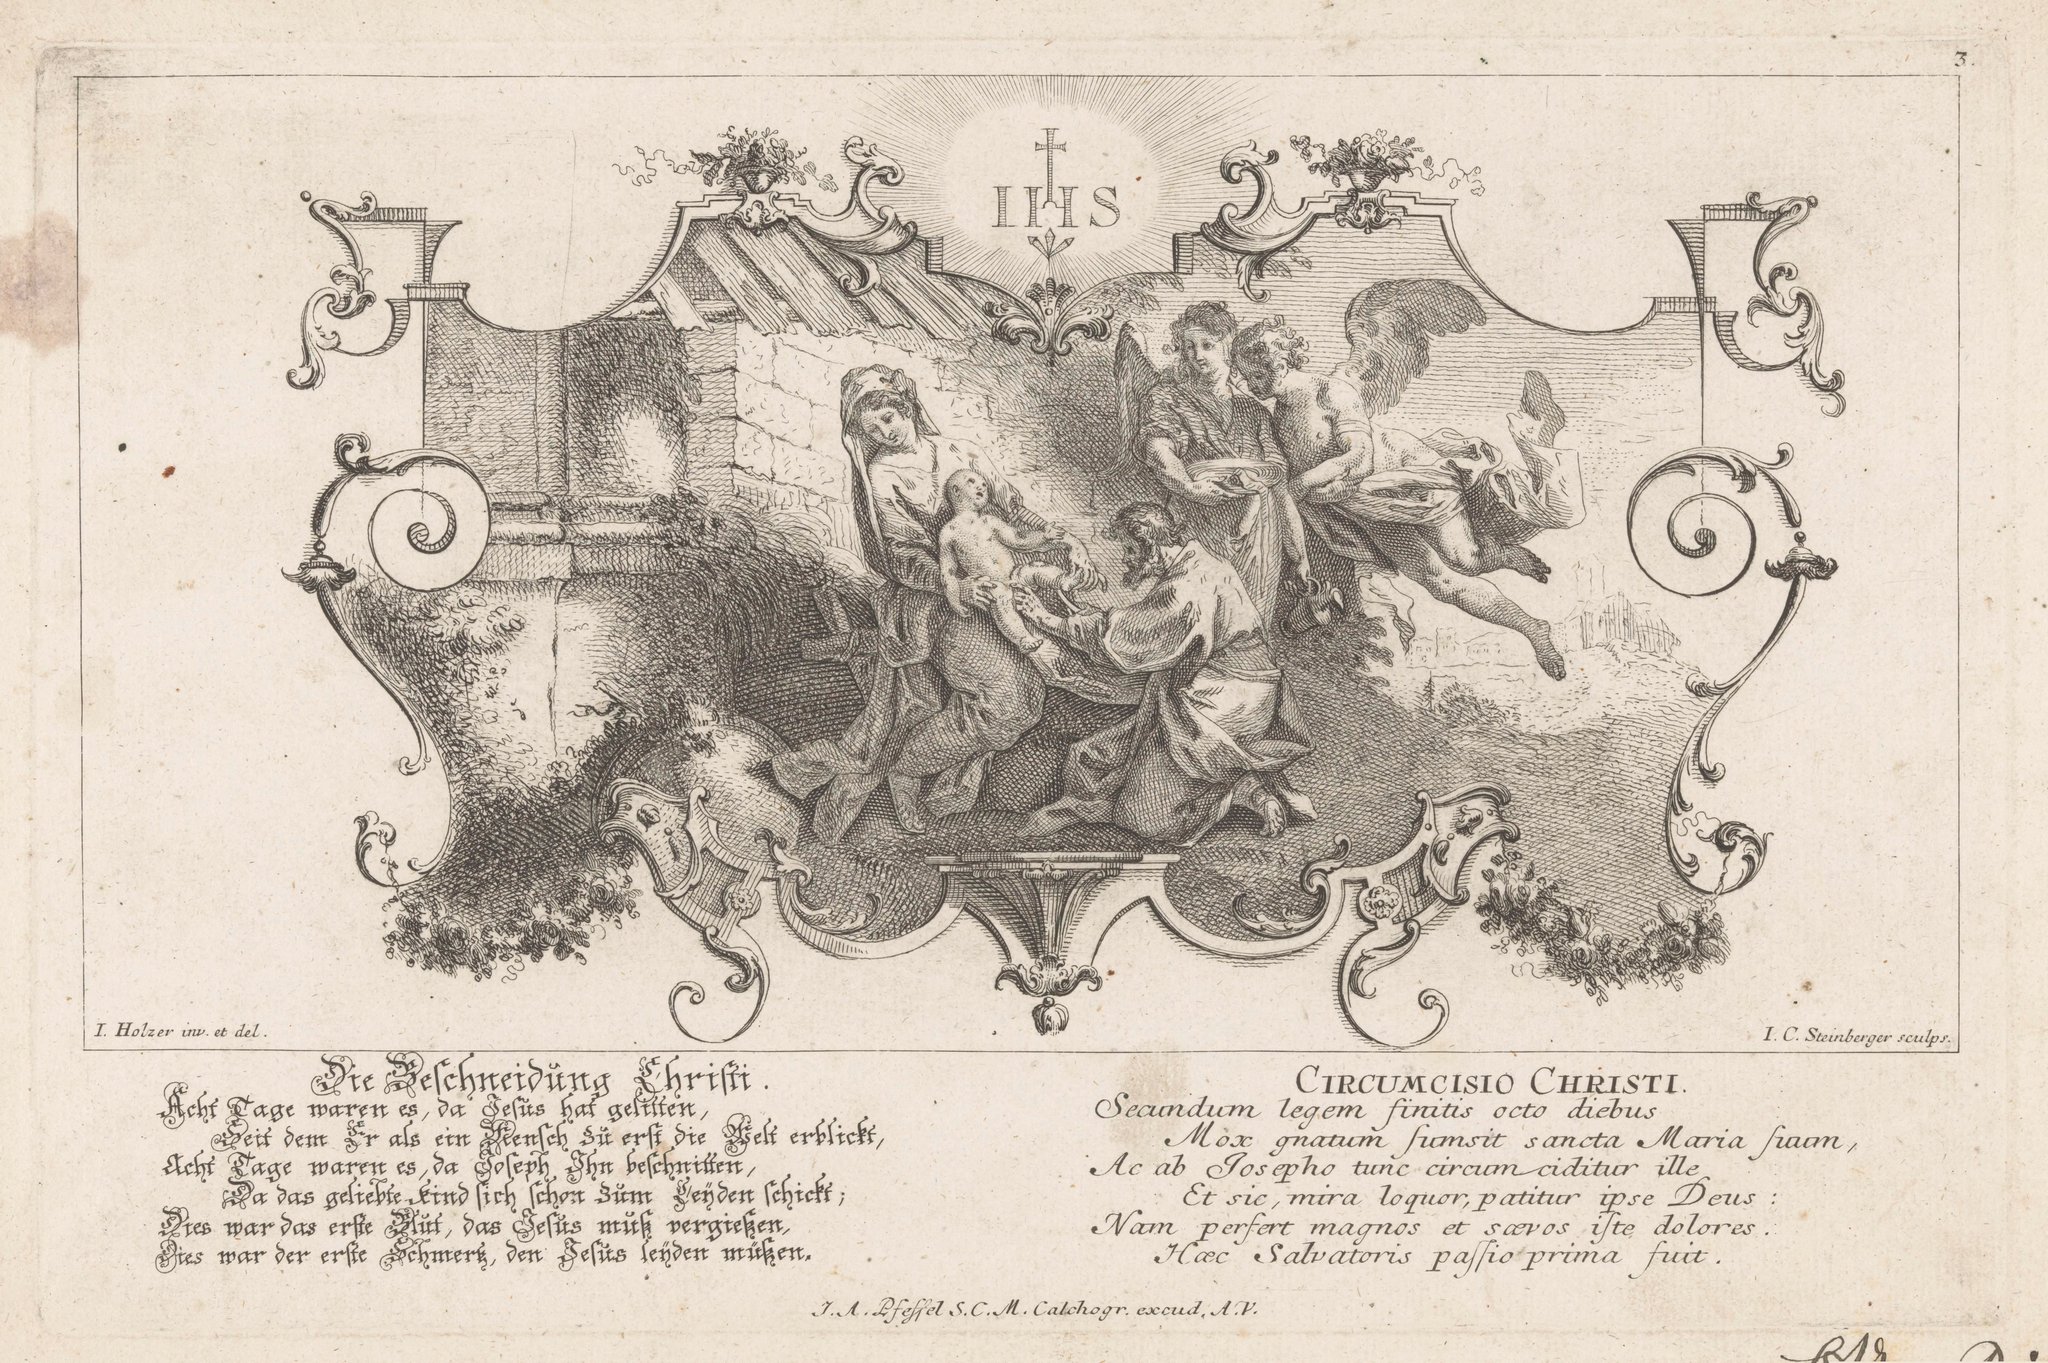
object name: print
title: Besnijdenis van Christus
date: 1719-1727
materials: paper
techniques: etching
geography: augsburg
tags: circumcision of the christ-child by the priest in the temple (luke 2:21)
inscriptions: inscription: ‘LAJ van Riel’, collector's mark: Lugt 2228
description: De besnijdenis van Christus. Een priester besnijdt het Christuskind dat bij Maria op schoot zit. Rechts in het landschap kijken twee engelen toe. Rondom de voorstelling een rocaille omlijsting met de letters IHS. In de ondermarge tweemaal een zevenregelige Duitse en Latijnse tekst.